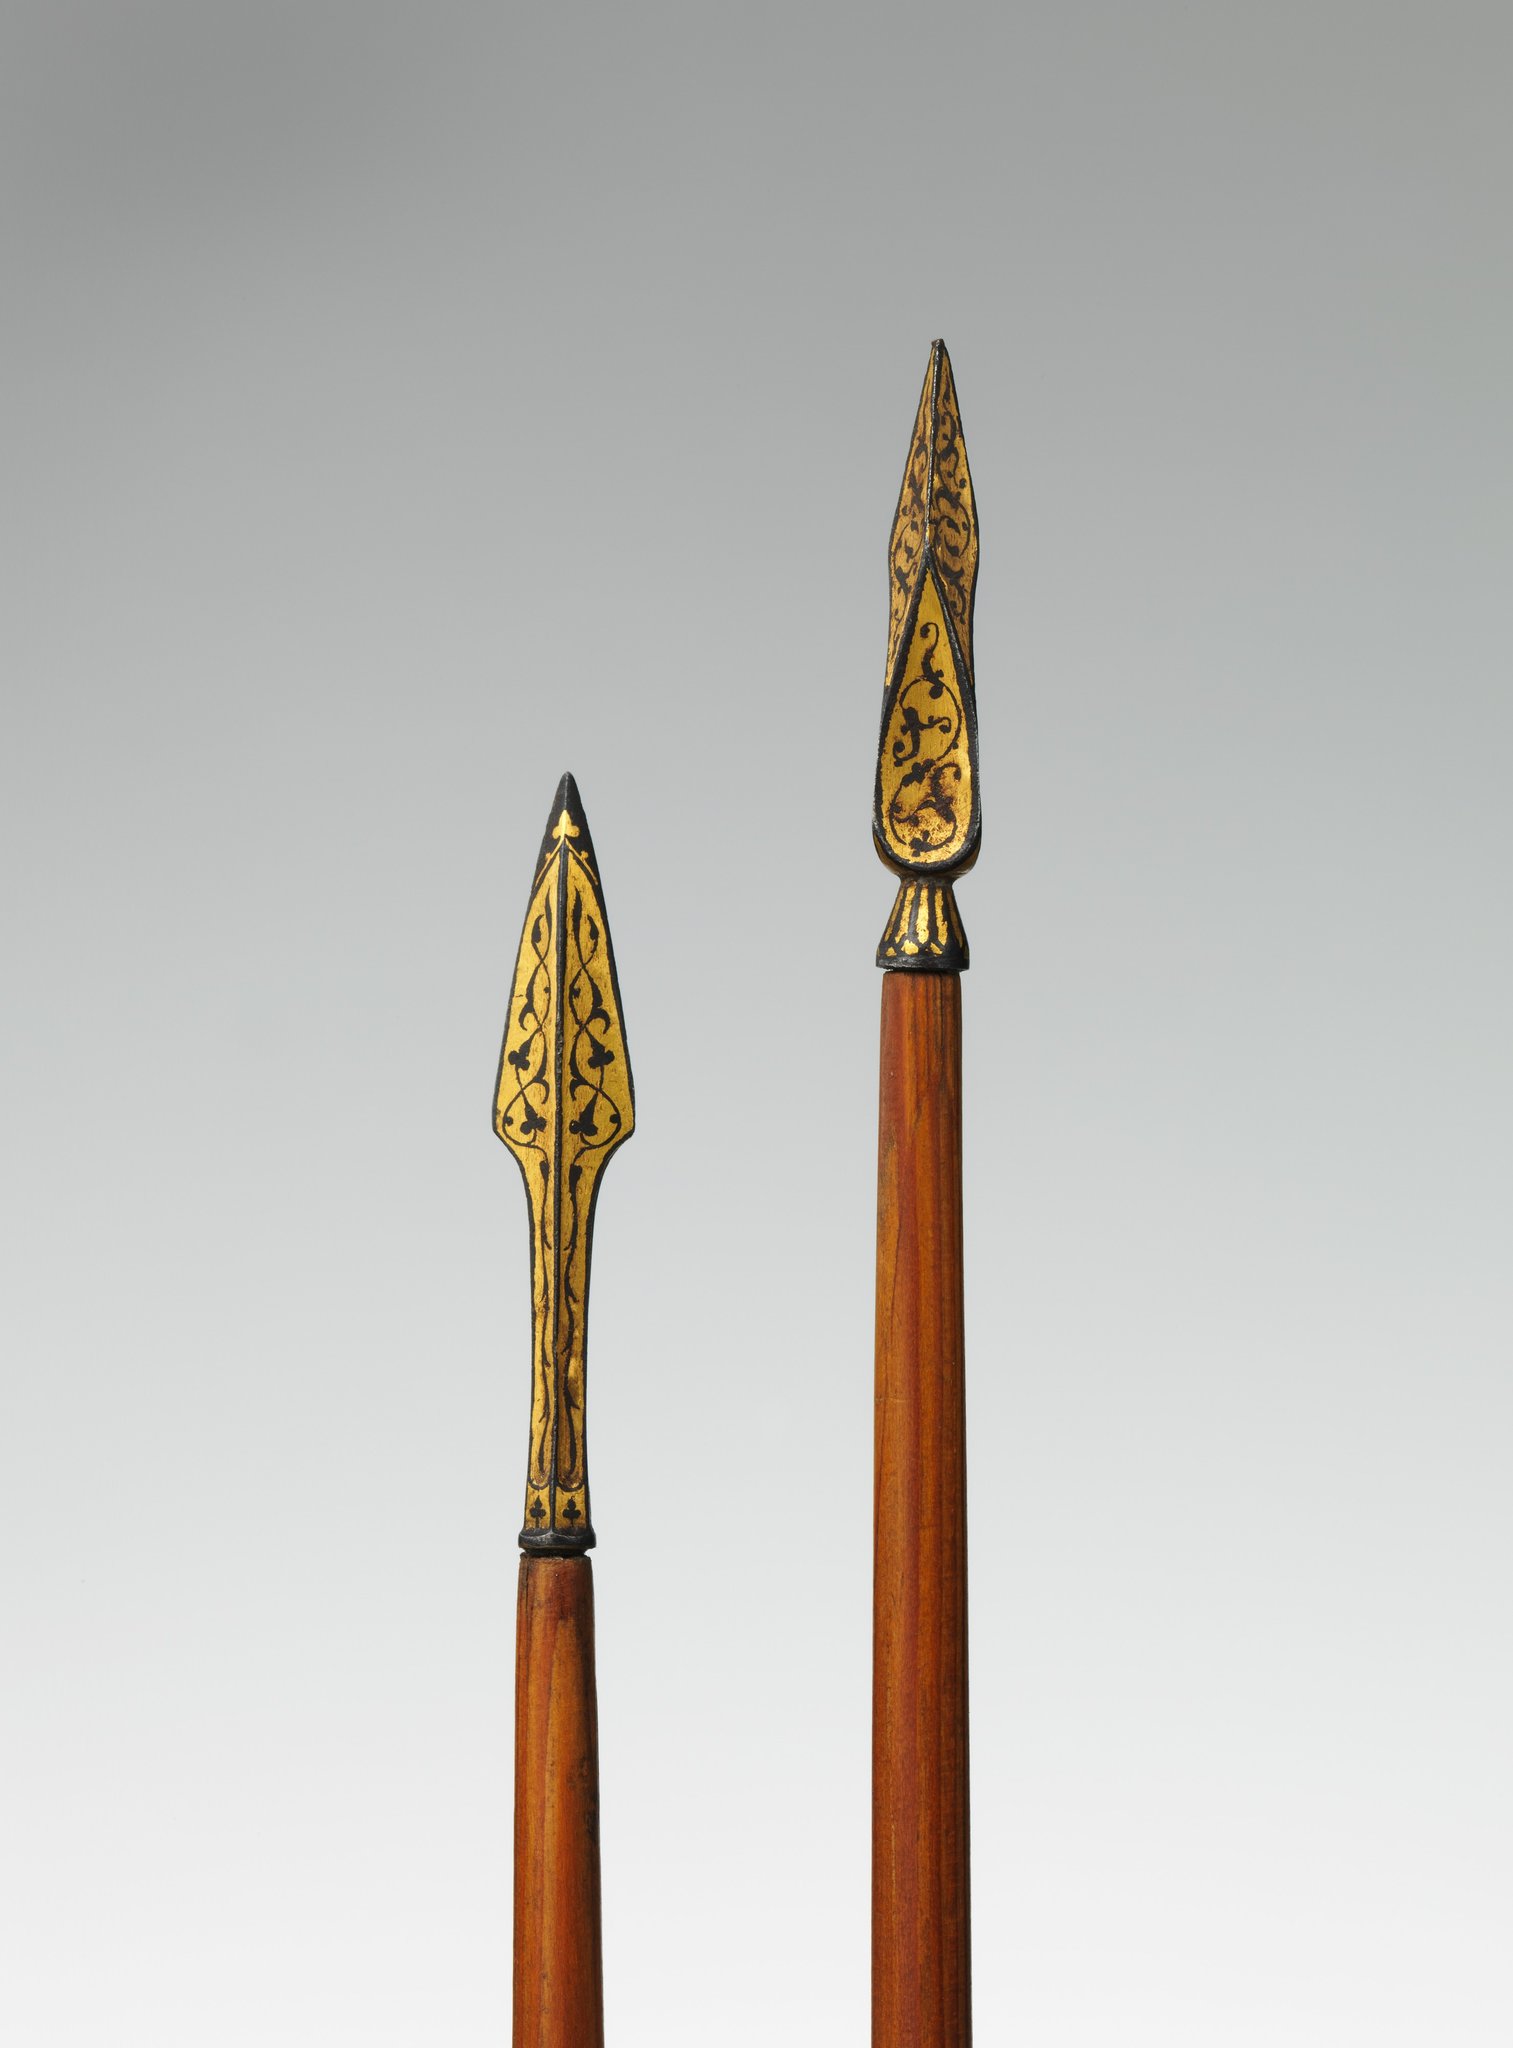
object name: two arrow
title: Two Arrows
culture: iranian or turkish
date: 1501-1600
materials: copper alloy, gold, lacquer, steel, textile, wood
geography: iran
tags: arrows